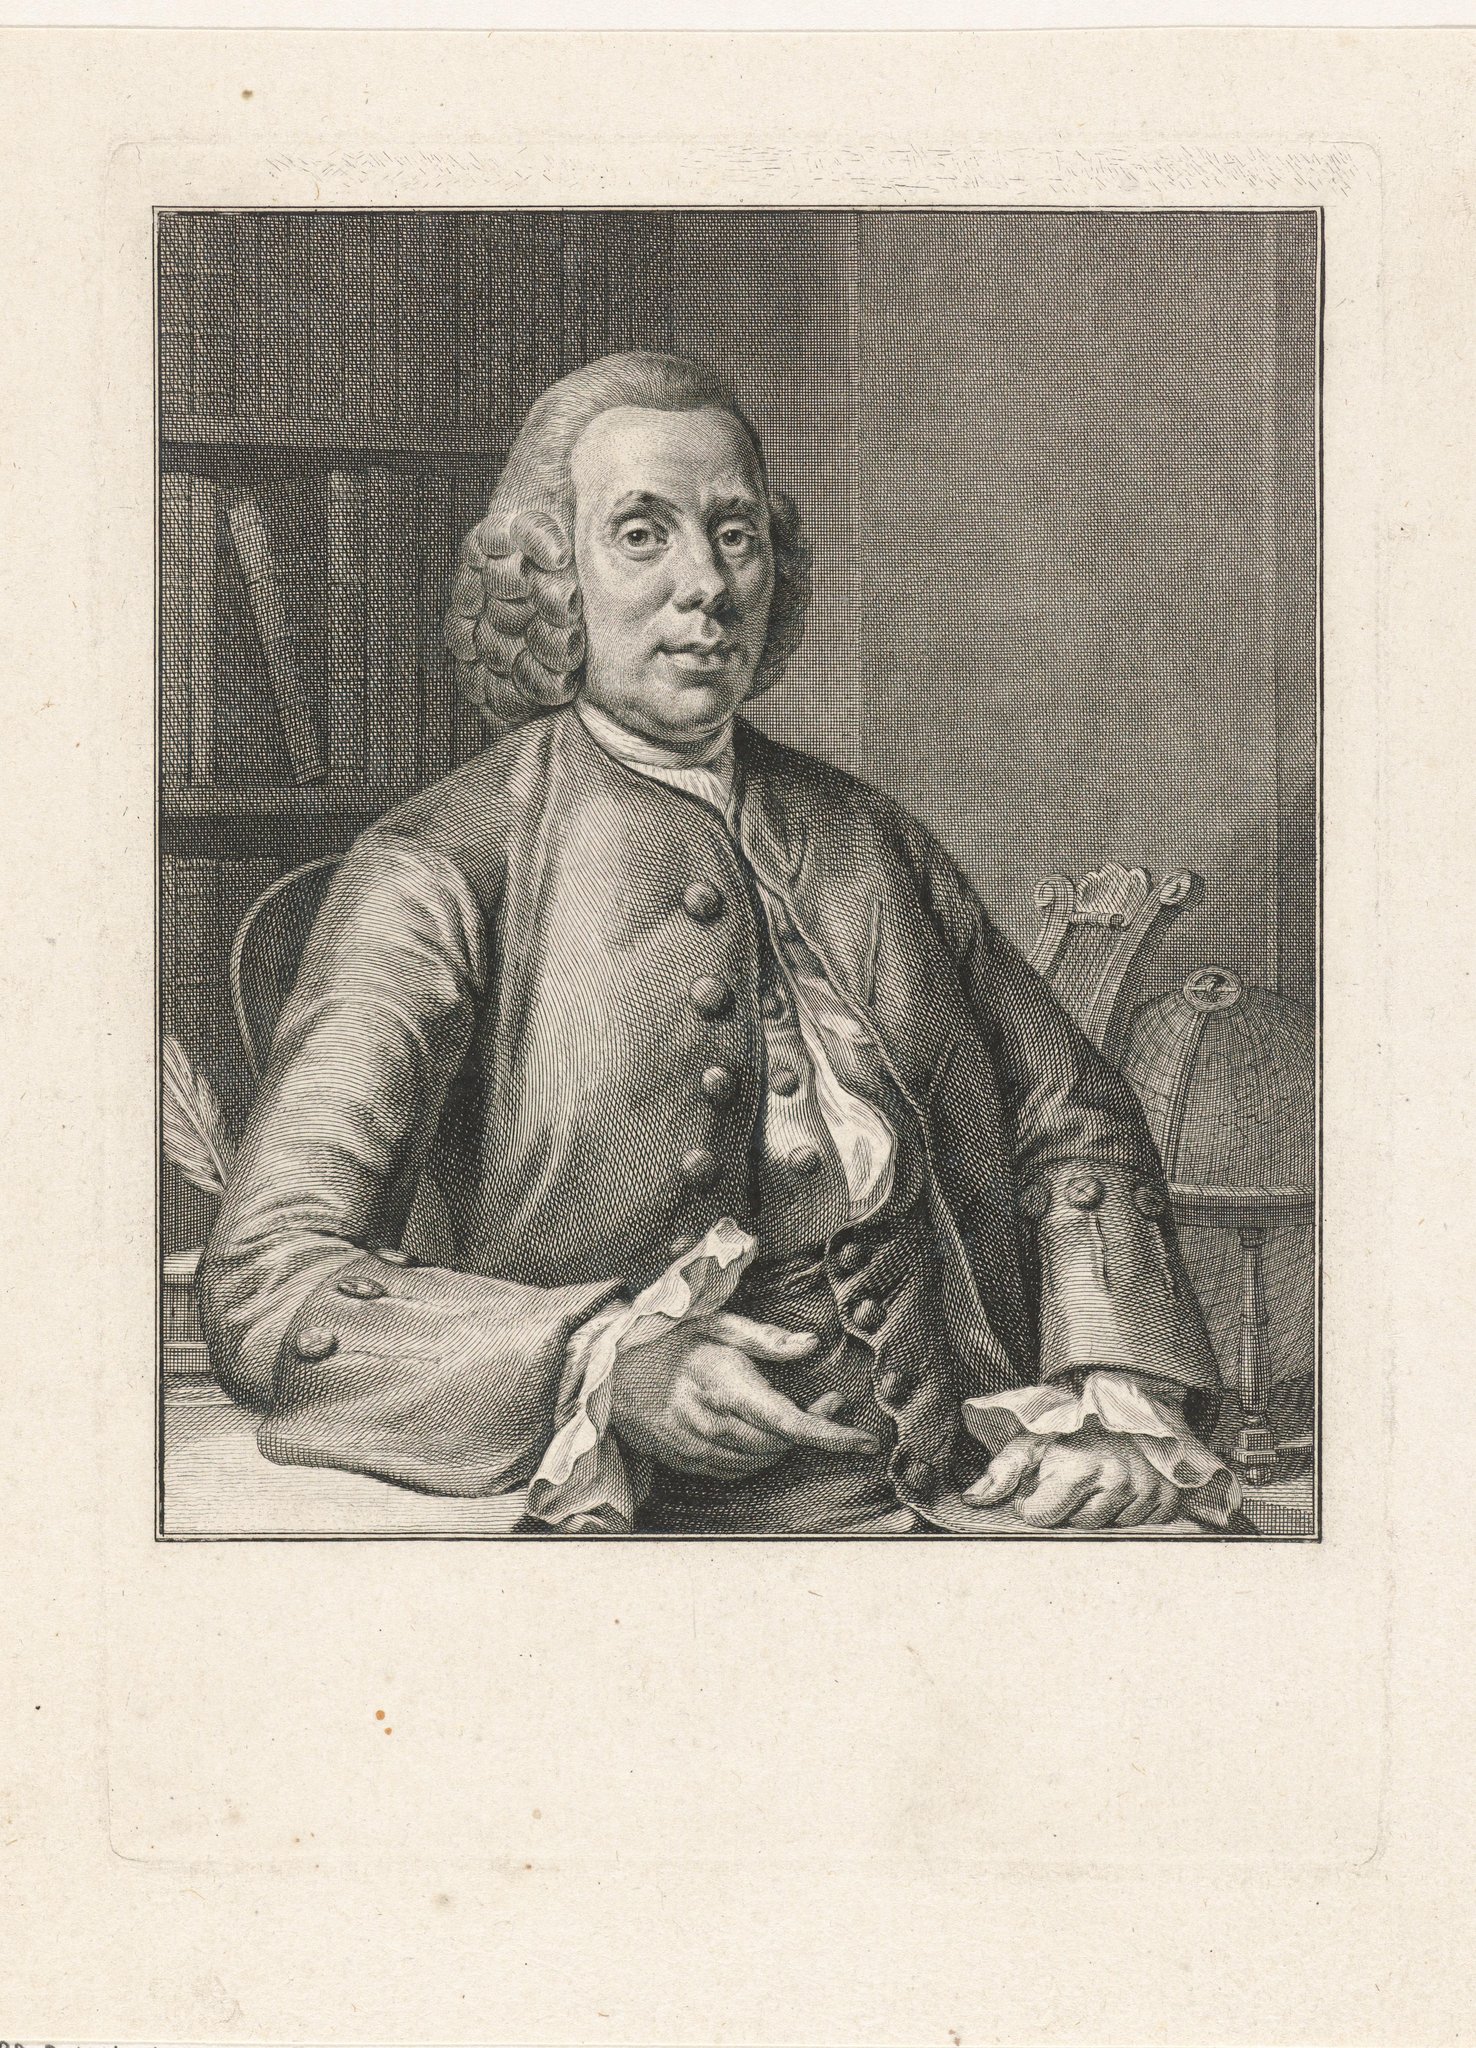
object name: print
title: Portret van Nicolaas Simon van Winter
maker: jacob houbraken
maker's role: draughtsman, print maker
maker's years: 1698-1780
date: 1771-1773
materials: paper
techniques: engraving, etching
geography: amsterdam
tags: nicolaas simon van winter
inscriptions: collector's mark: Lugt 2228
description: Portret van de dichter Nicolaas Simon van Winter.